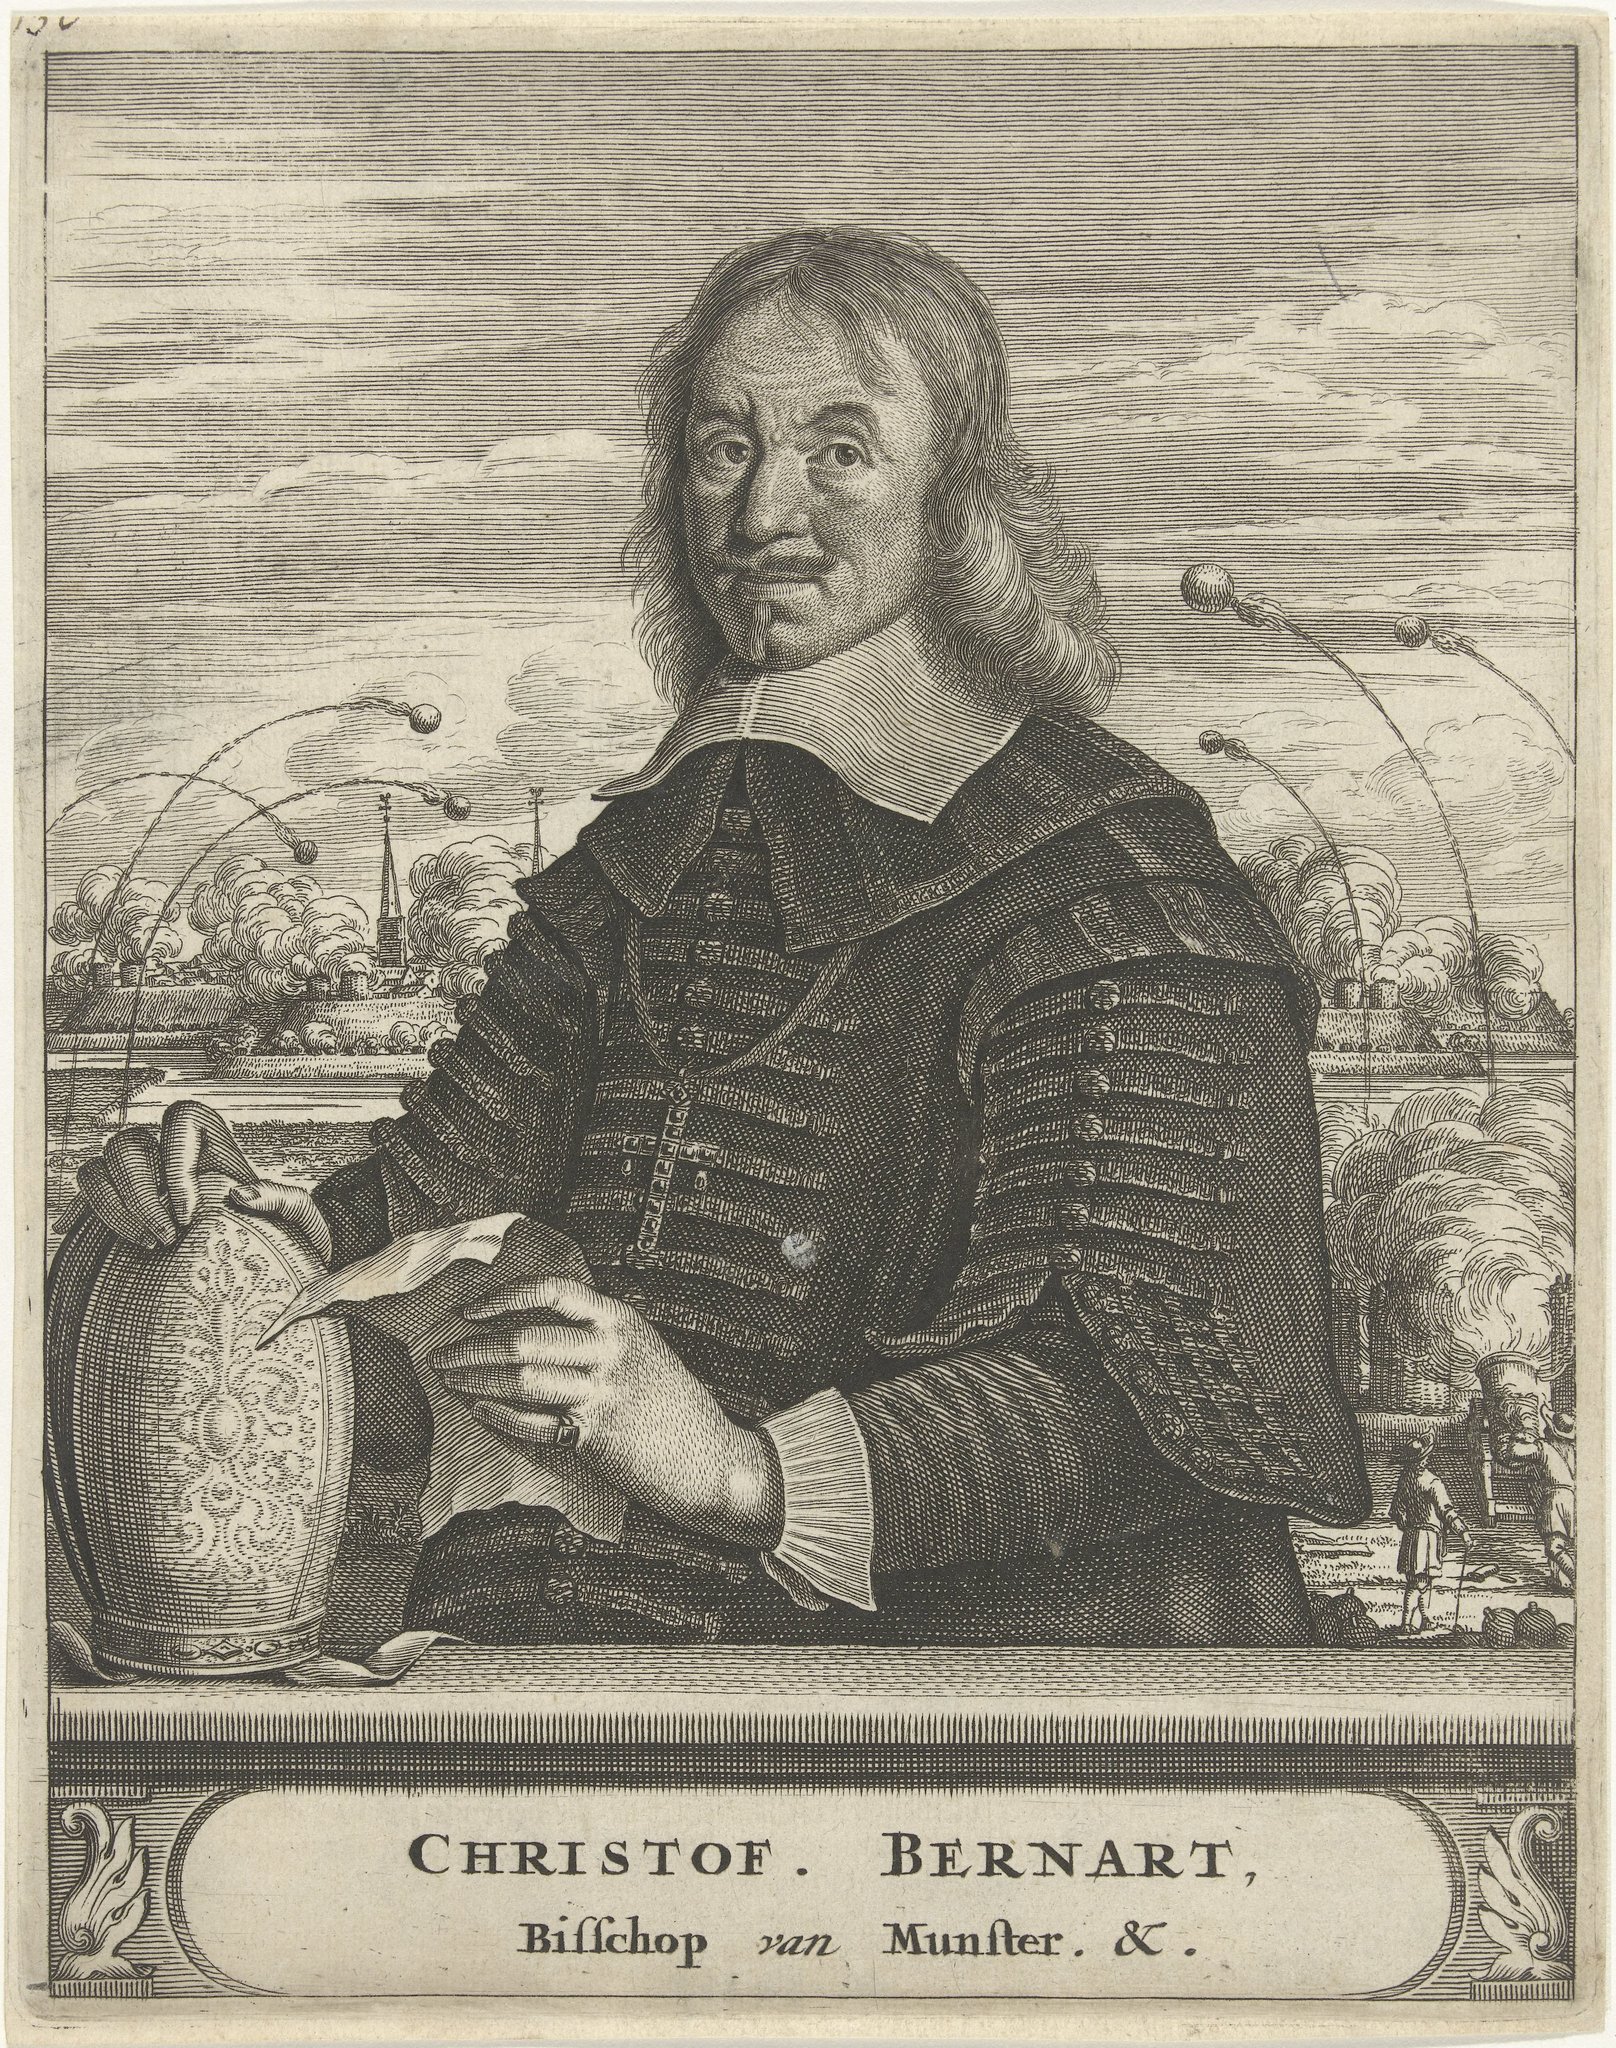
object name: print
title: Portret van Christoph Bernhard von Galen, bisschop van Münster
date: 1675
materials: paper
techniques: engraving, etching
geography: amsterdam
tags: insignia of bishop, e.g. mitre, crozier, paper (writing material), bombardment, firearms (+ during the battle)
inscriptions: collector's mark: Lugt 2228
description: Prent gebruikt in: Bos, Lambert van den. Tooneel des Oorlogs (...). Amsterdam: Jacob van Meurs en Johannes van Someren, 1675. En in: Bos, Lambert van den. Schauplatz des Krieges: Aufgerichtet in den Vereinigten Niederlanden: (...). Amsterdam: Jacob van Meurs, 1675, p. 164. Prent voorheen toegeschreven aan Pieter van Gunst (zie inventarisnummer RP-P-1912-747).